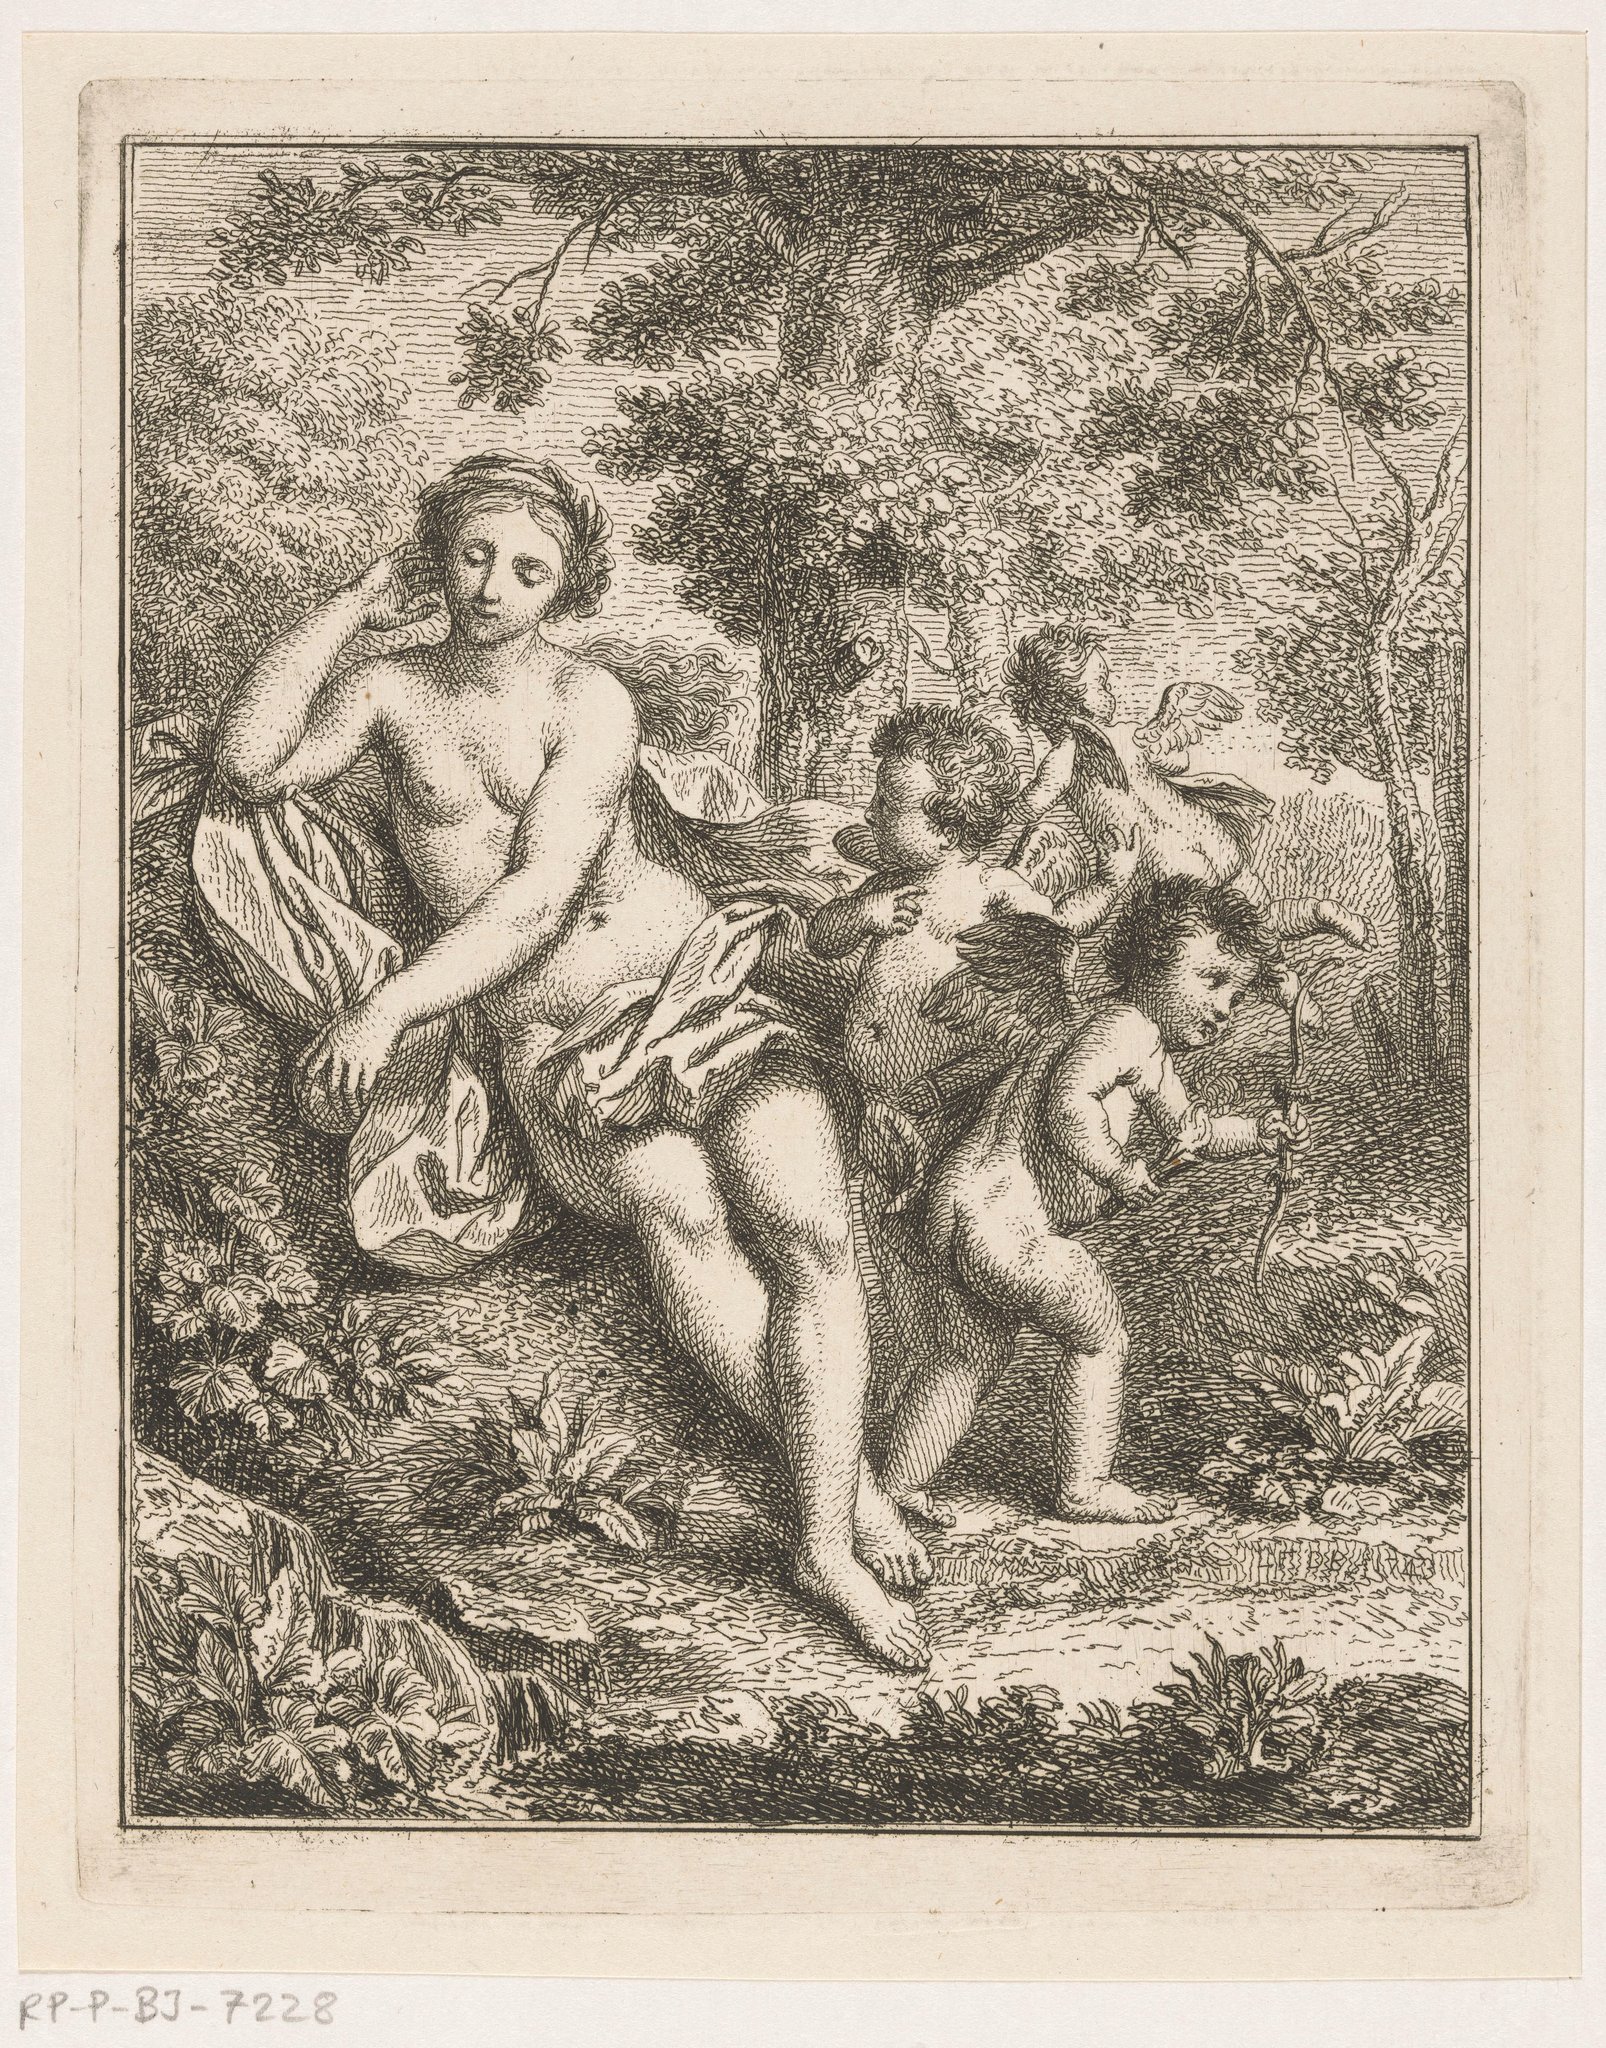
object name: print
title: Venus, Amor en twee putti in een arcadisch landschap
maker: louis fabritius dubourg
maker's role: draughtsman, print maker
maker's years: 1693-1775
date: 1713-1775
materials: paper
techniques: etching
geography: amsterdam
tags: pastorals, arcadian scenes, venus and cupid (cupid not being mere attribute)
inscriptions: collector's mark: Lugt 240